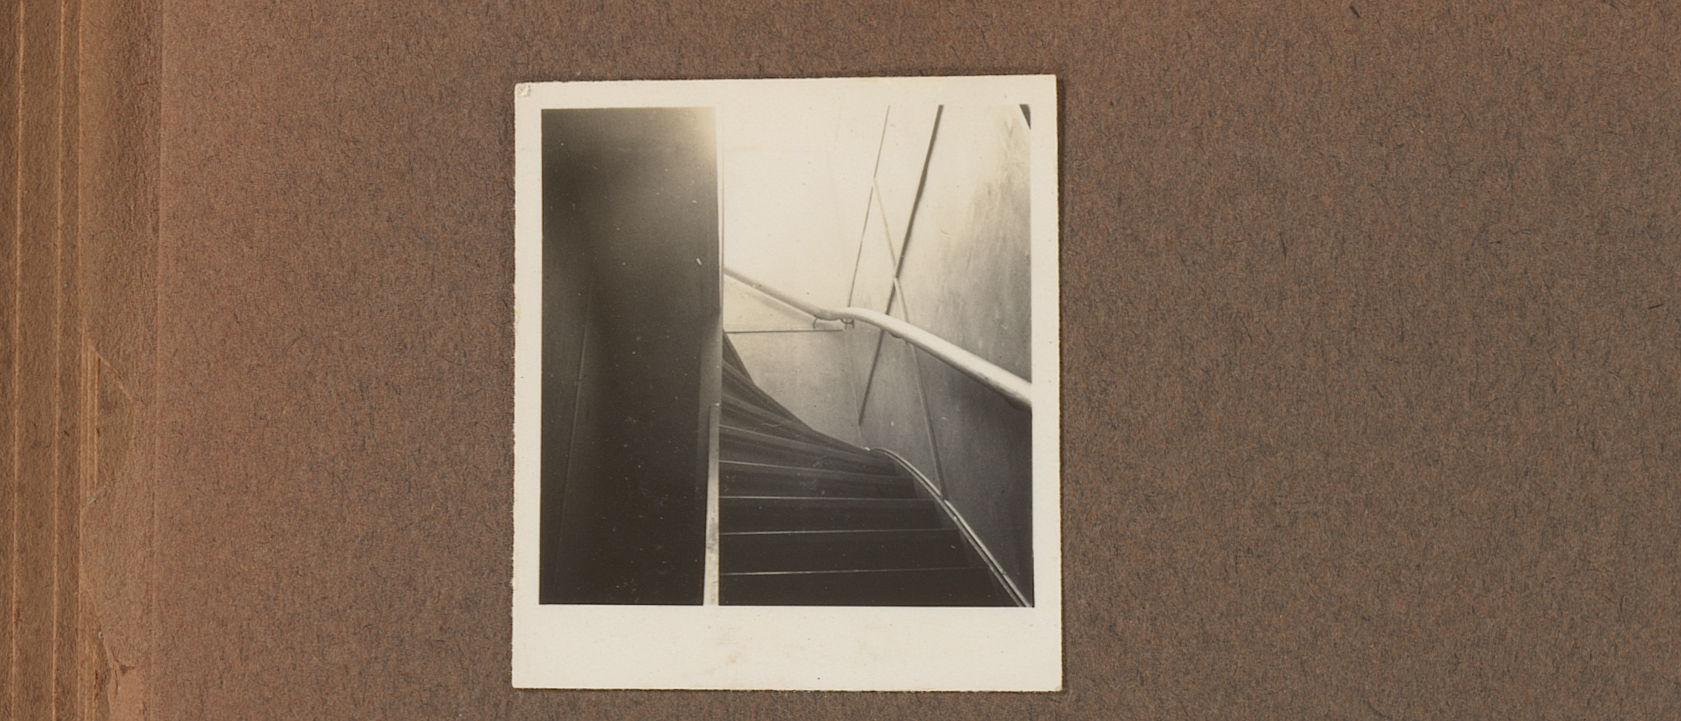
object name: photograph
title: Trap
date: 1900-1920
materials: photographic support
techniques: photography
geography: netherlands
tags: amsterdam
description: Foto op bruin albumblad 56 van familiealbum van Alphons Diepenbrock.